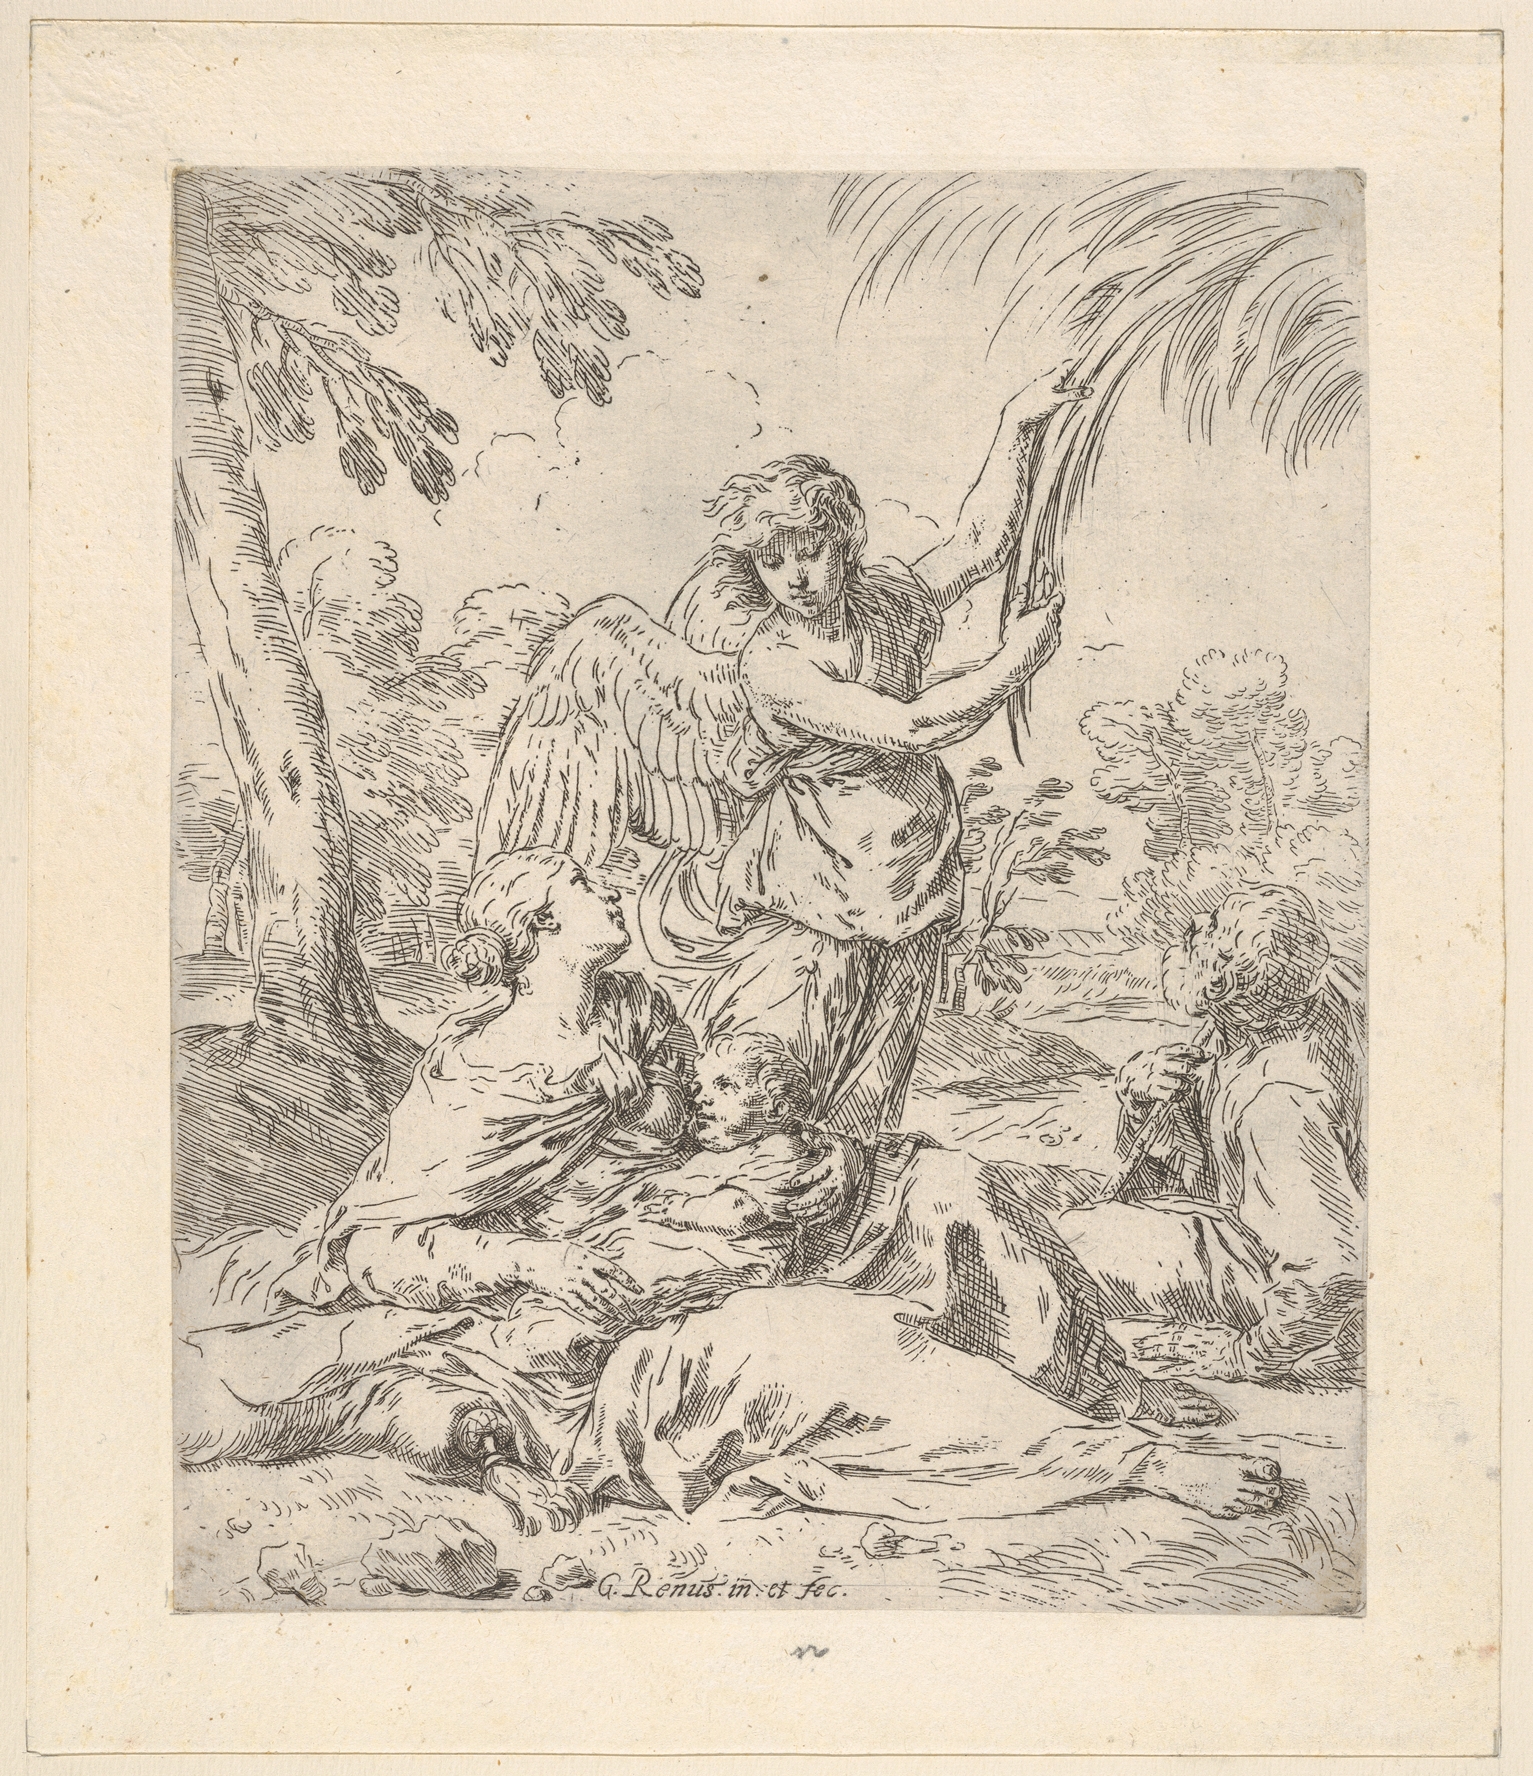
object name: print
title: Repose in Egypt, Mary nursing the infant Christ while an angel pulls at tree branches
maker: simone cantarini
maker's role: artist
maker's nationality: italian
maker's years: 1612-1648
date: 1630-1648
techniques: etching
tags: angels,virgin mary,jesus